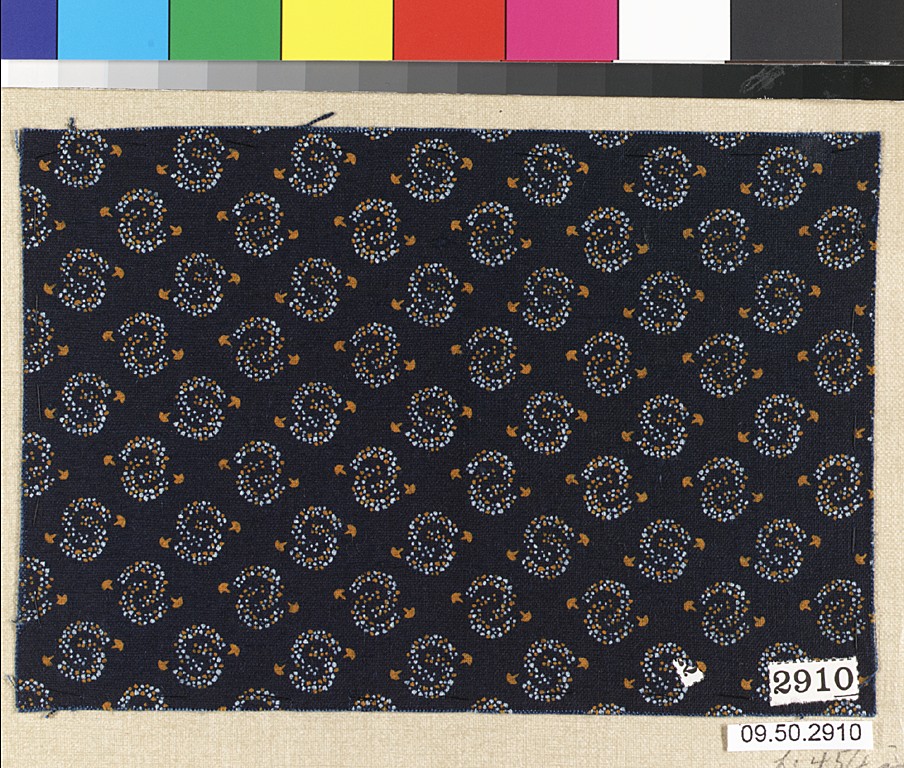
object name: piece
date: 1801-1900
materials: cotton